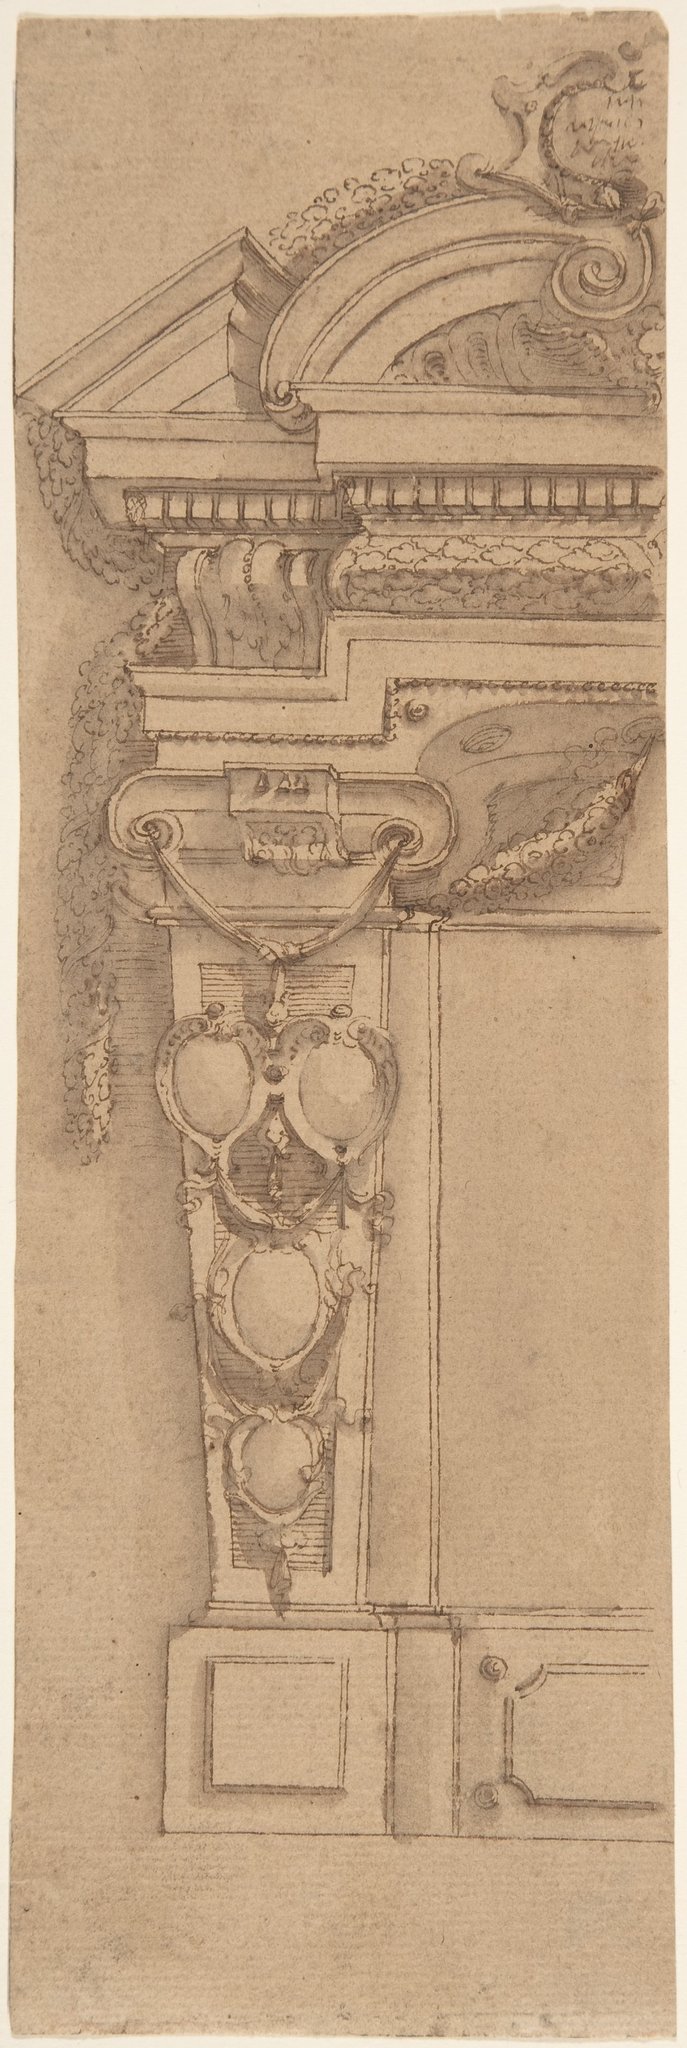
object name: drawing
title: Left Half Design for Wall Monument with Escutcheon Motif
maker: anonymous, italian, 17th century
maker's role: artist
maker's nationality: italian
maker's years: 1600-1700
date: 1601-1700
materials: ink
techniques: brush, pen, wash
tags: monuments